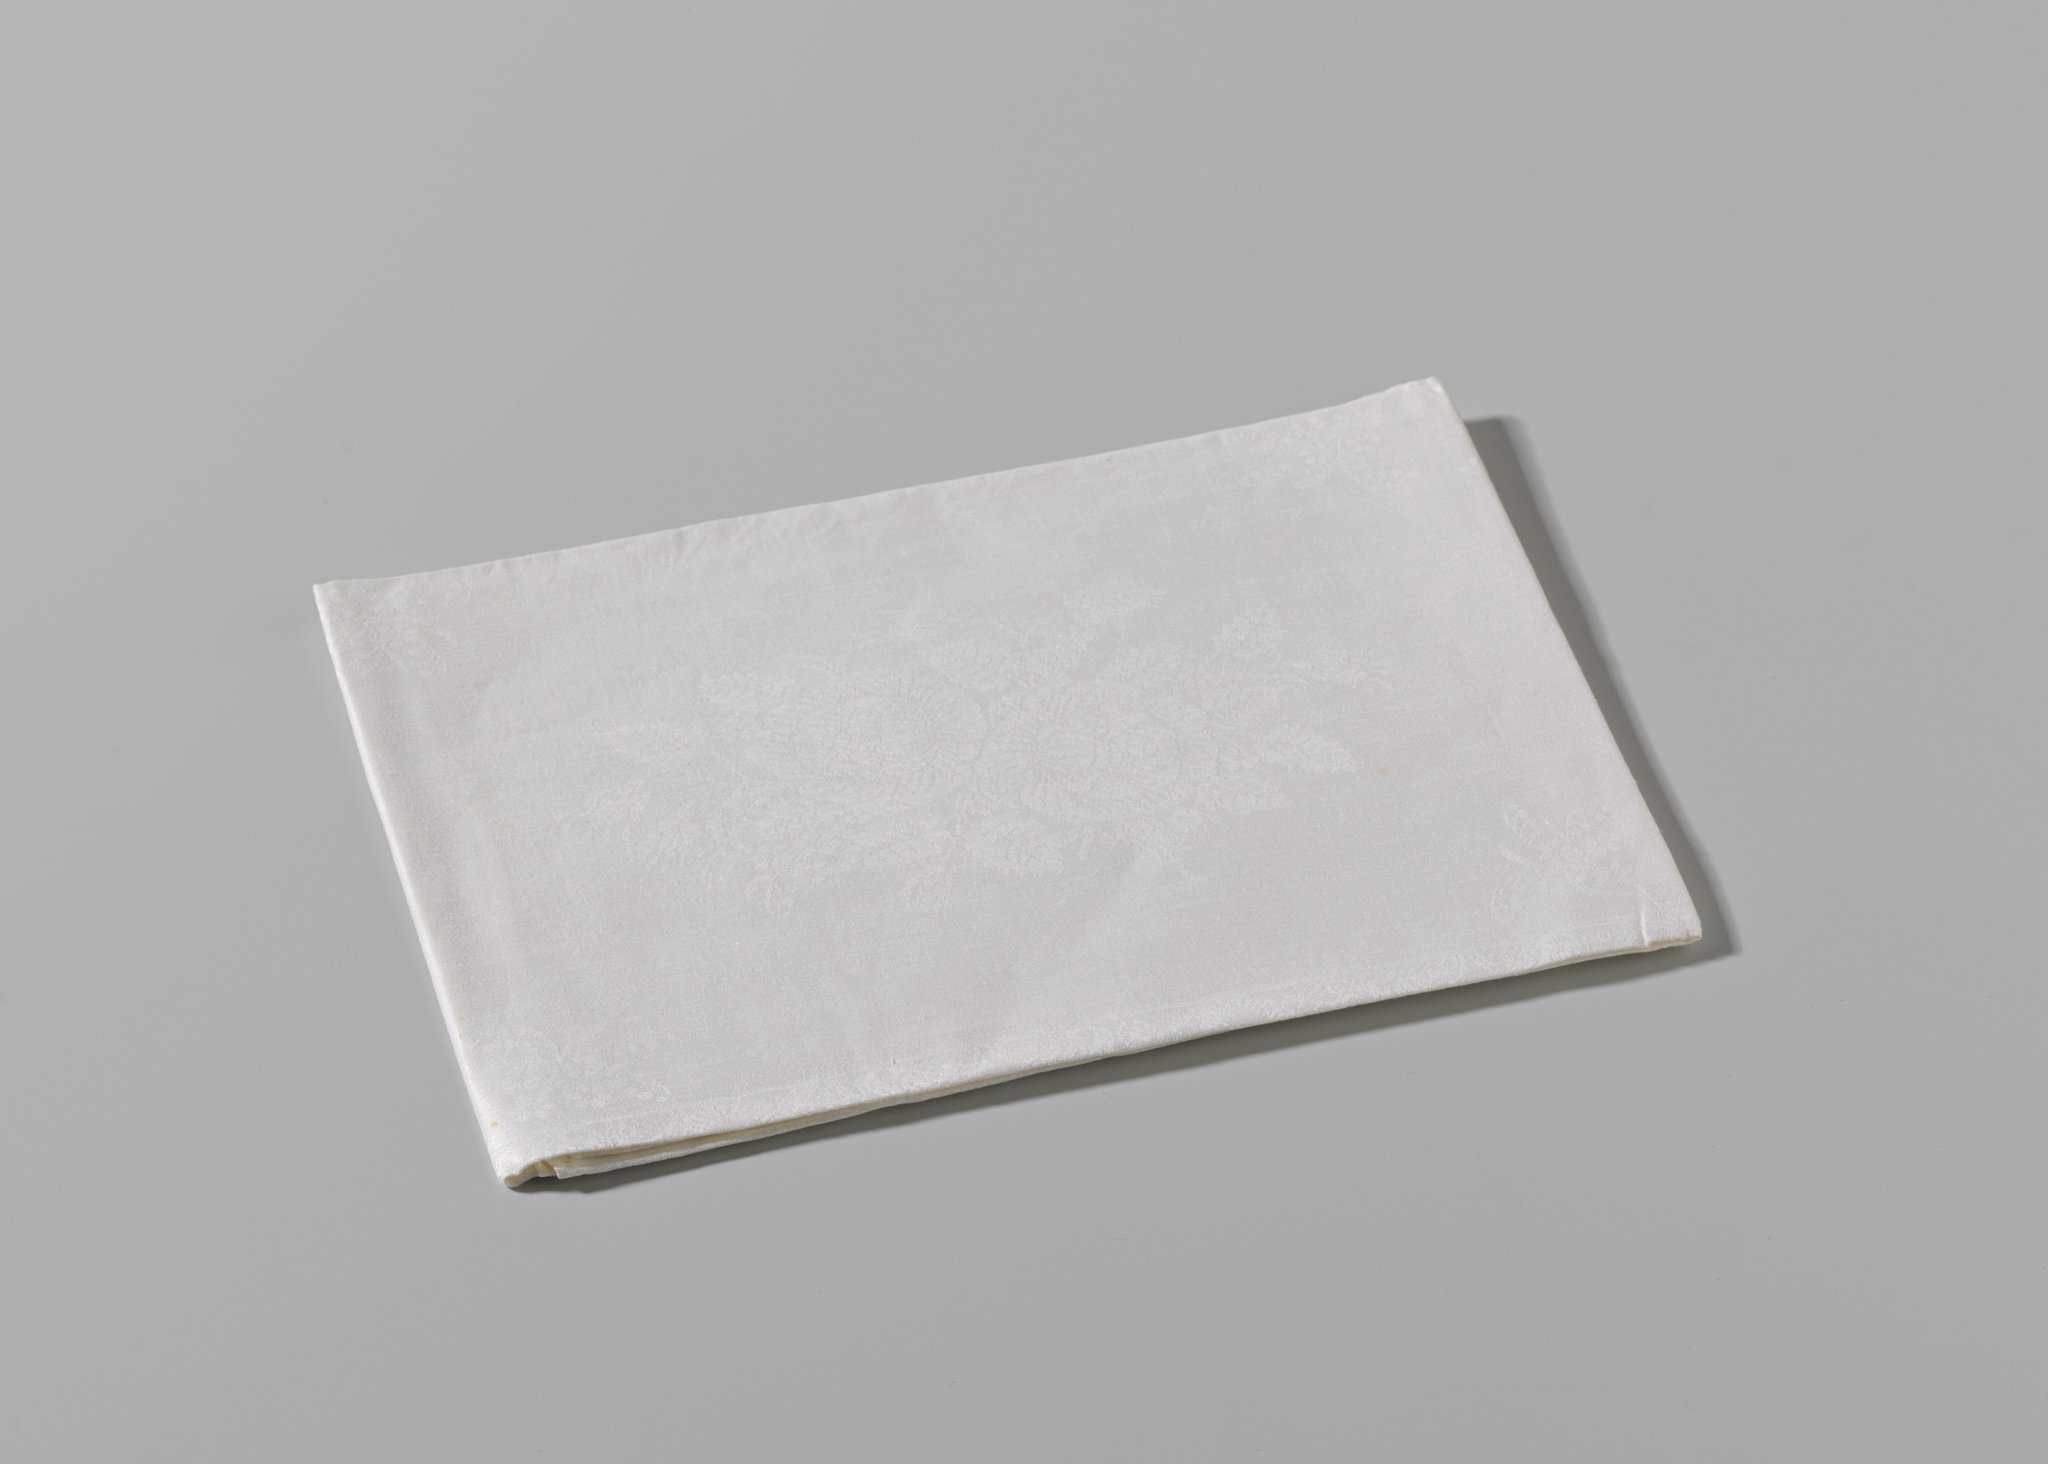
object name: napkin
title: Servet met rozen en vergeet-mij-nietjes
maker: Anonymous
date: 1725-1749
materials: linen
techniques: damask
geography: dresden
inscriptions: mark: ‘BS 18’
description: Servet van linnendamast met rozen en vergeet-mij-nietjes. Rozen- afgewisseld met vergeet-mij-niettuiltje. Brede rand met fijne symmetrische rocaillemotieven met rastervulling en met naar binnen gerichte bloemenvazen, waarin drie afwisselende bloembouquetten. Binnenzoom van C-motieven; buitenbegrenzing van bloemslingers. Rondom: blokkenrand.